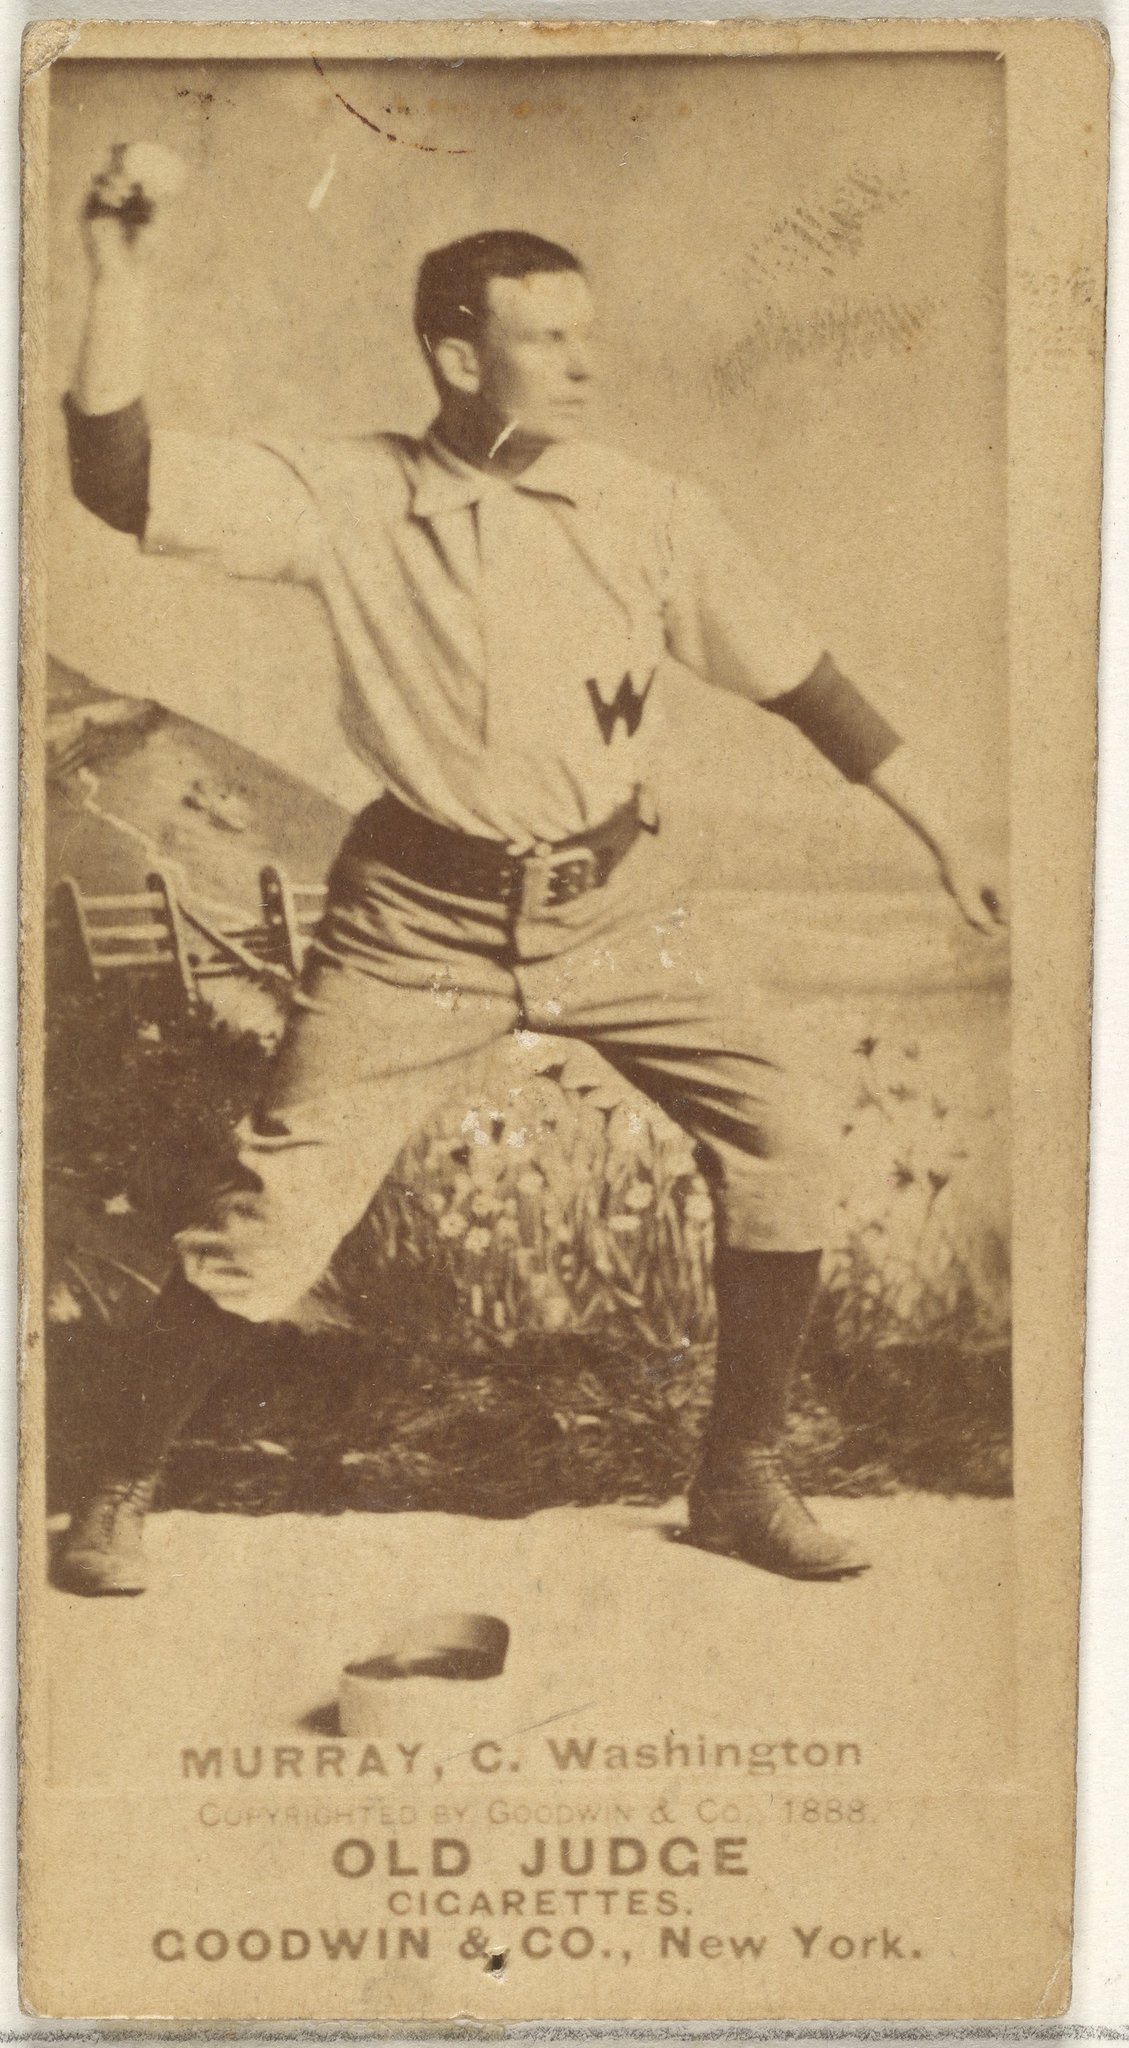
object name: baseball card, photograph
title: Jeremiah J. "Miah" Murray, Catcher, Washington Nationals, from the Old Judge series (N172) for Old Judge Cigarettes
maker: goodwin & company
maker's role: publisher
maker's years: 1850-1950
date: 1888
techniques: albumen silver print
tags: men,portraits,baseball,athletes